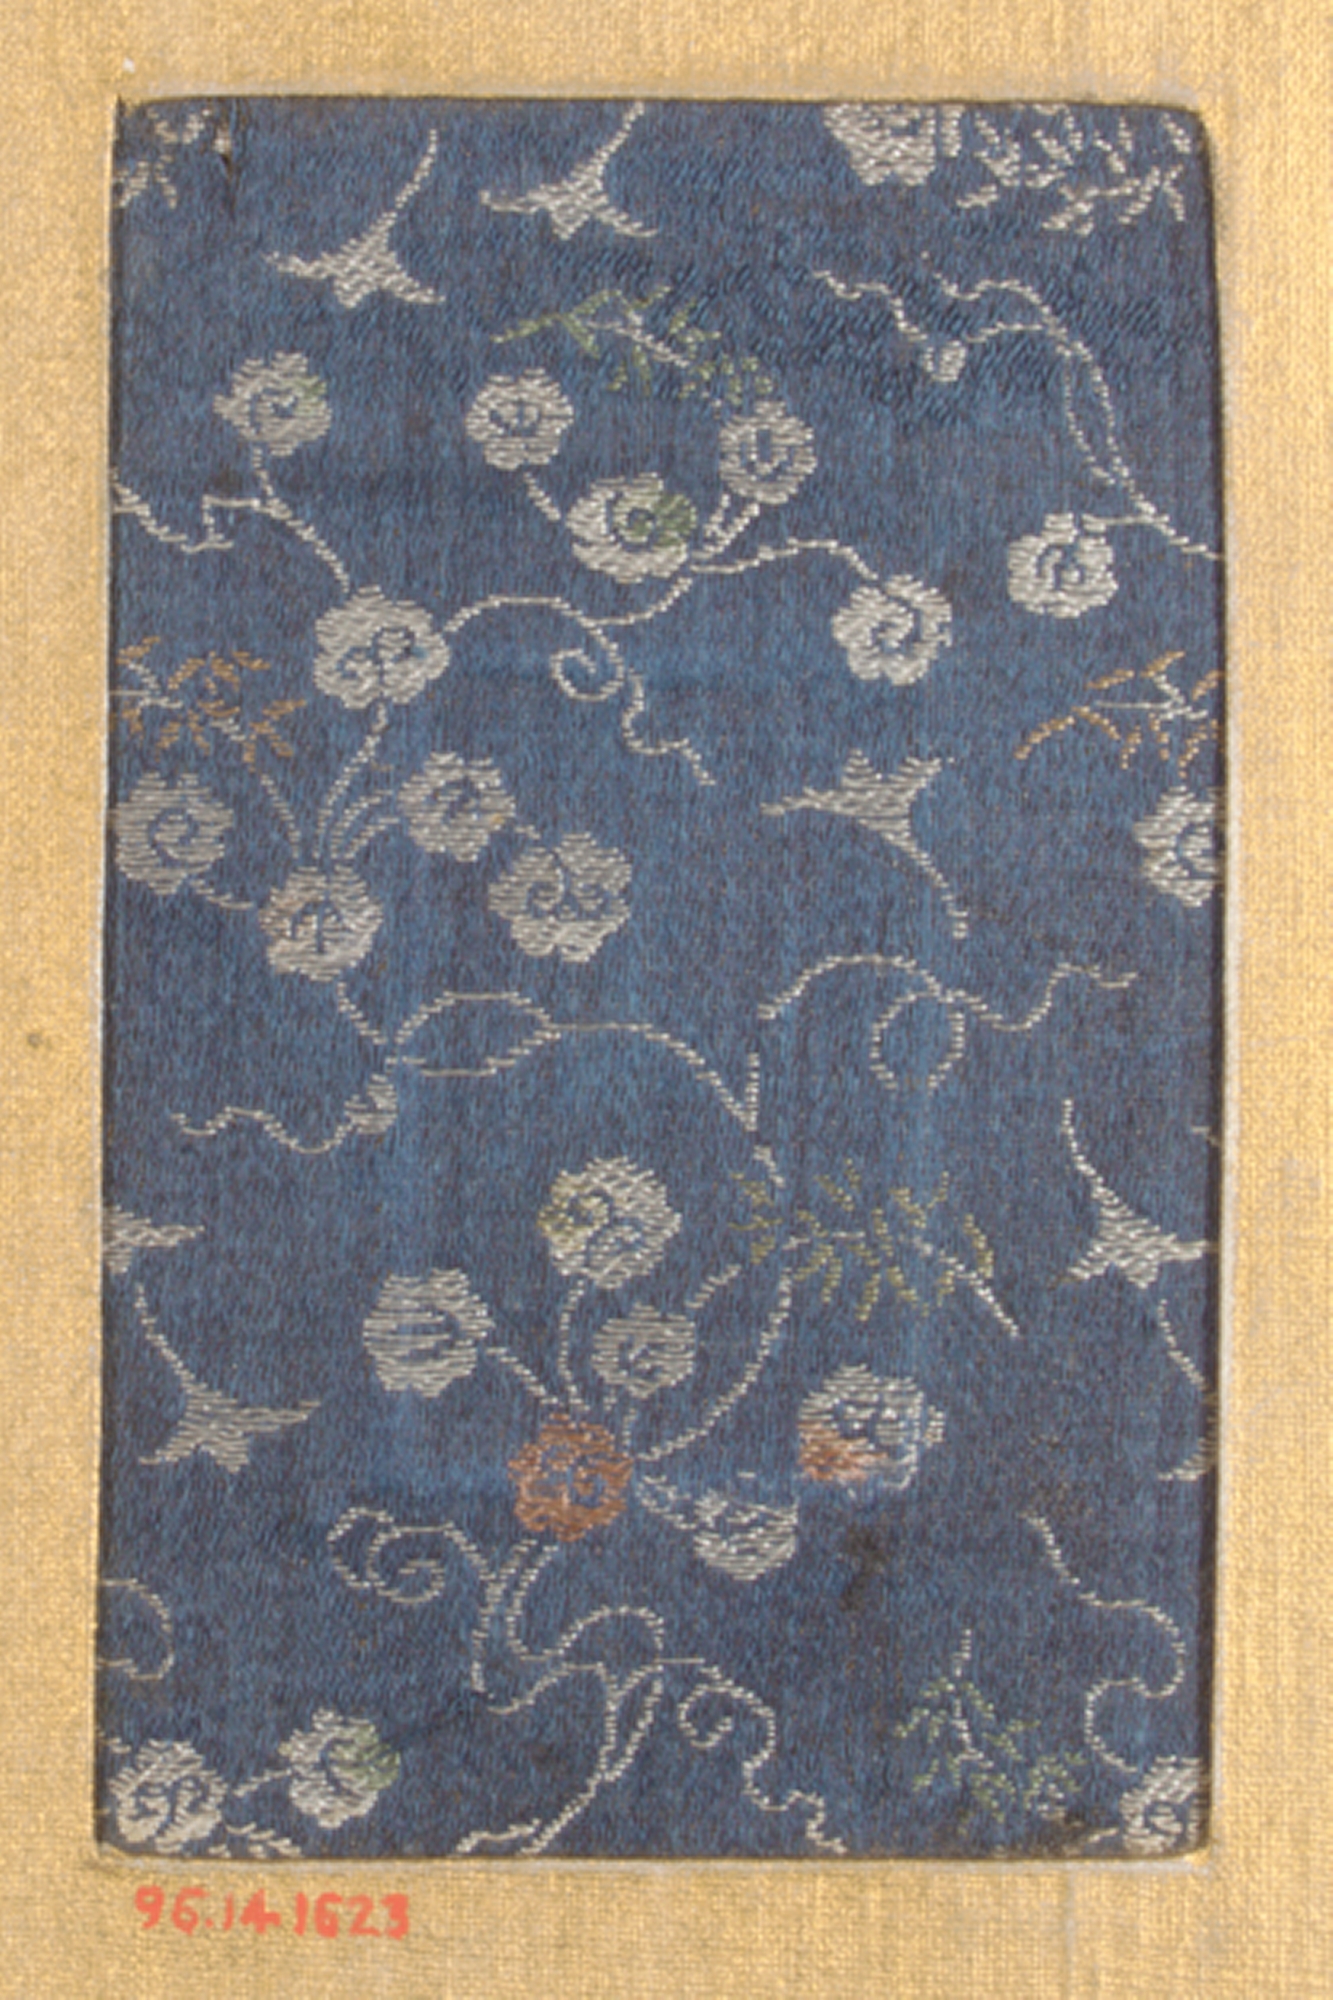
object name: piece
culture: japanese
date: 1701-1900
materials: silk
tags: flowers